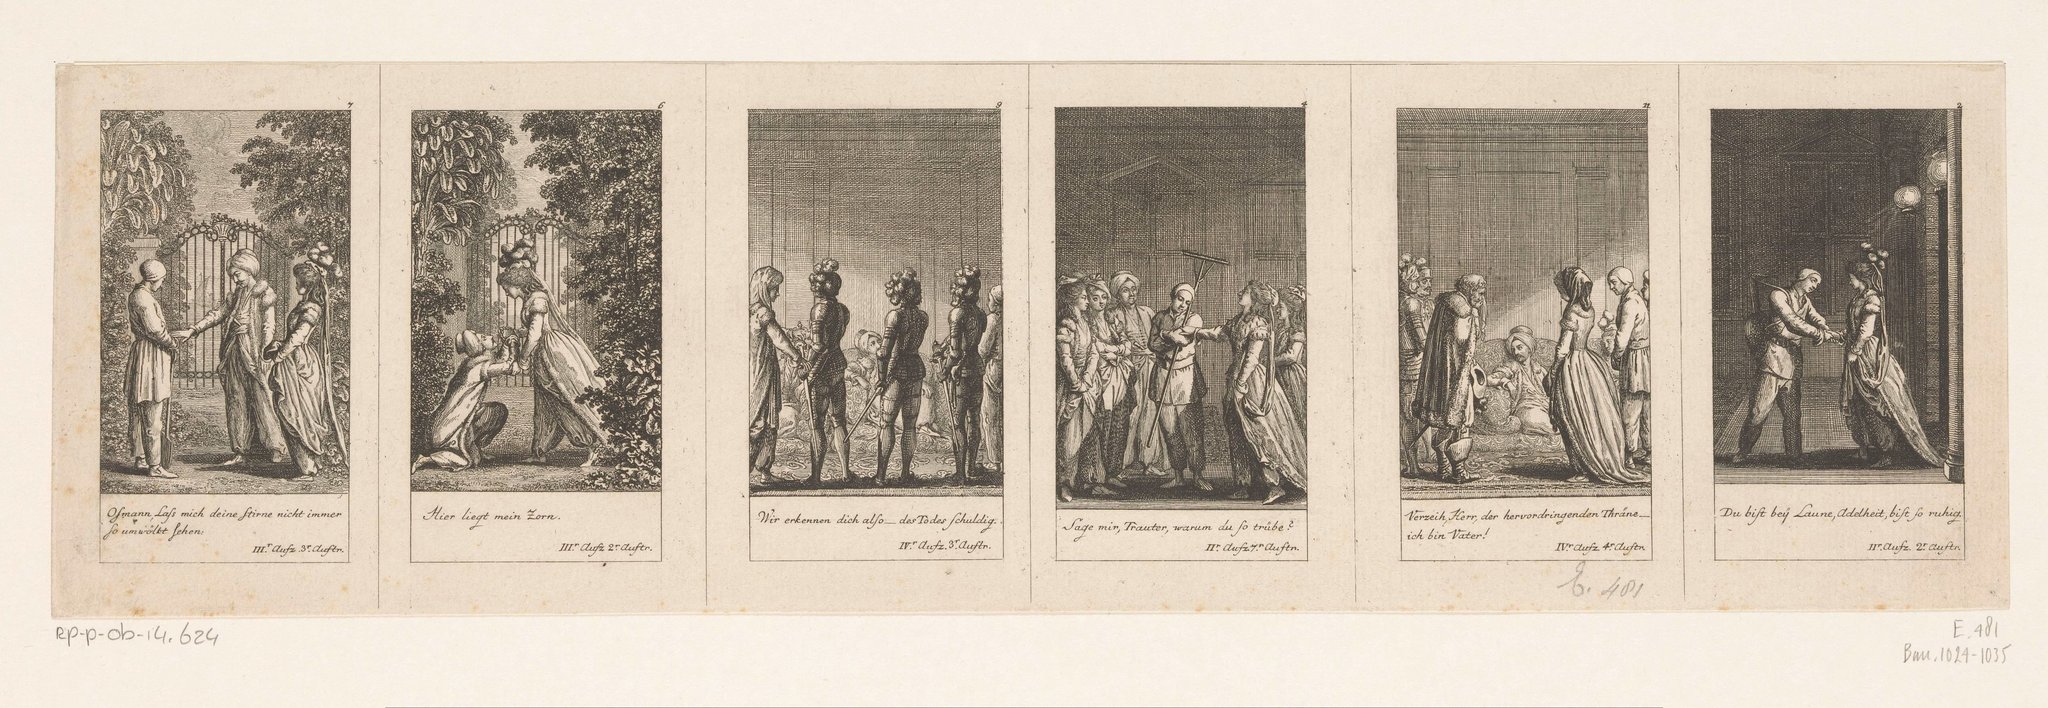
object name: print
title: Zes voorstellingen uit Adelheid von Veltheim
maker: daniel nikolaus chodowiecki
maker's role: draughtsman, print maker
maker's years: 1726-1801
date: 1783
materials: paper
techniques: etching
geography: berlin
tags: berlin, landscapes, literature, gate, entrance, interior of the house, conversation, dialogue; conversation piece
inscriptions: collector's mark: Lugt 2228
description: Vervaardigd voor G. F. W. Grossmann's 'Adelheid von Veltheim'. Een latere staat gebruikt in: Königlich Grosbritannischer genealogischer Kalender auf das Jahr 1784. Lauenburg: Berenberg, 1783.